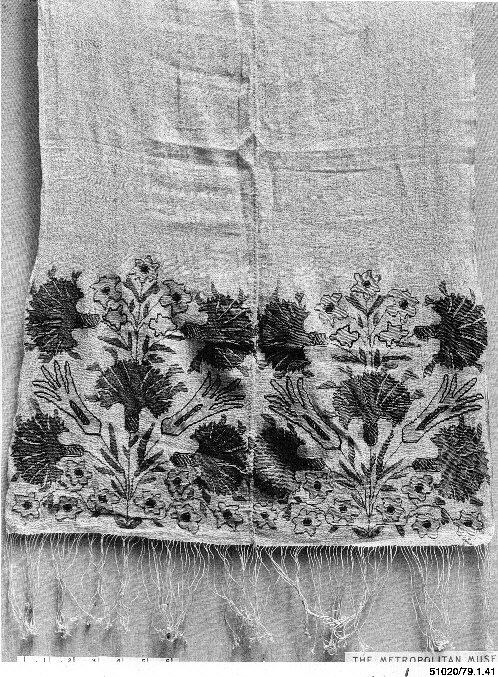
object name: towel end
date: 1801-1833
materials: linen, metal thread, silk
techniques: embroidery, weave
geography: turkey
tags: flowers